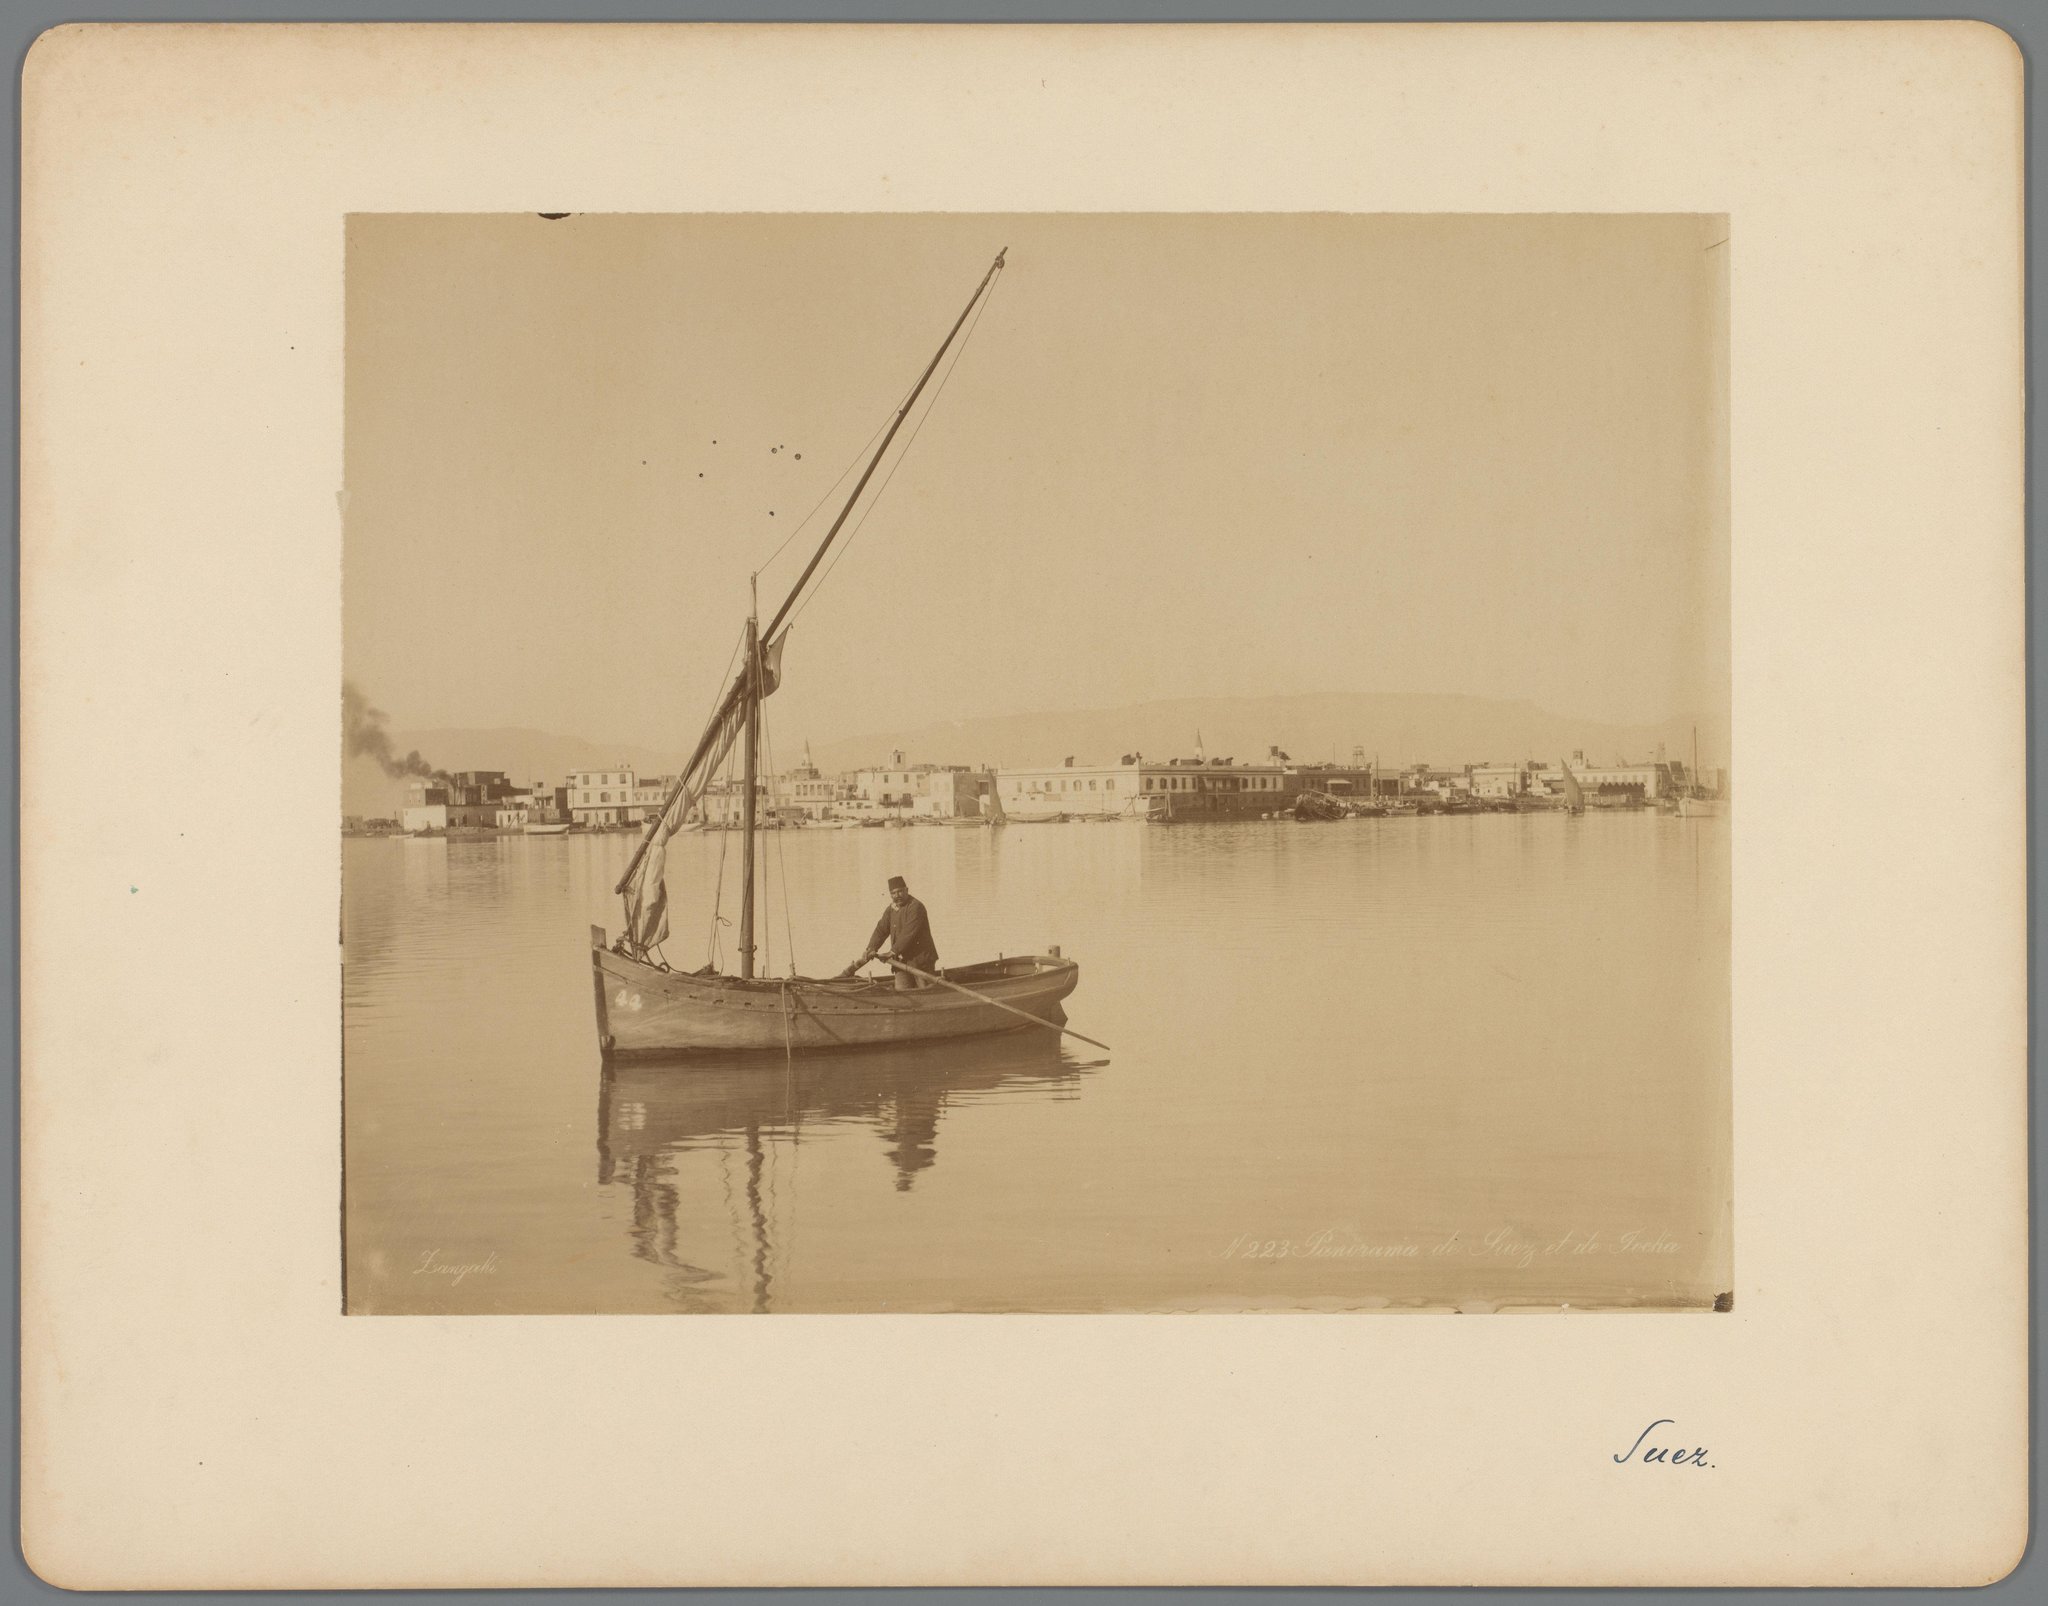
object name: photograph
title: Panorama de Suez et de Jocka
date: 1870-1895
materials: cardboard, paper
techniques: albumen print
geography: suez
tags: sailing-ship, sailing-boat, city-view in general; 'veduta'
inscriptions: inscription: ‘Foto’, inscription: ‘Suez’, number: ‘N 223’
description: Deze foto zat oorspronkelijk in prentenkabinet RP-F-AA3192.